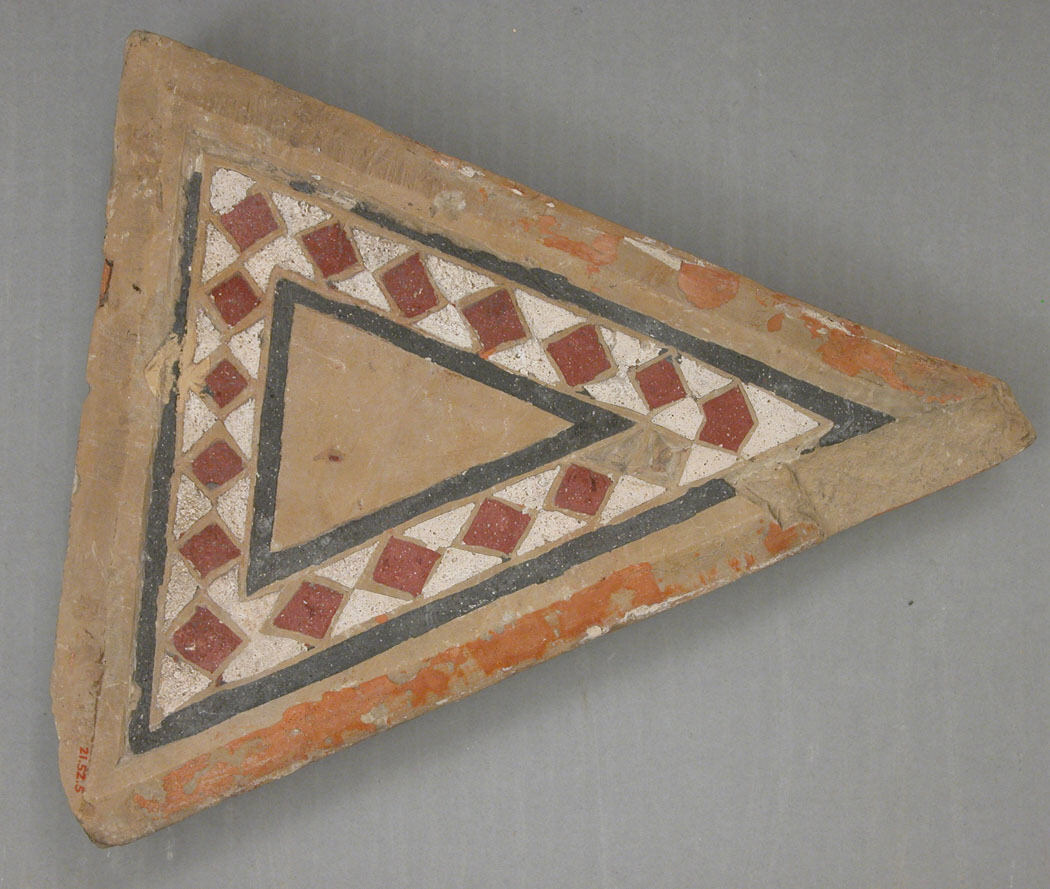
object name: tile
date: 1101-1400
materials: plaster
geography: egypt